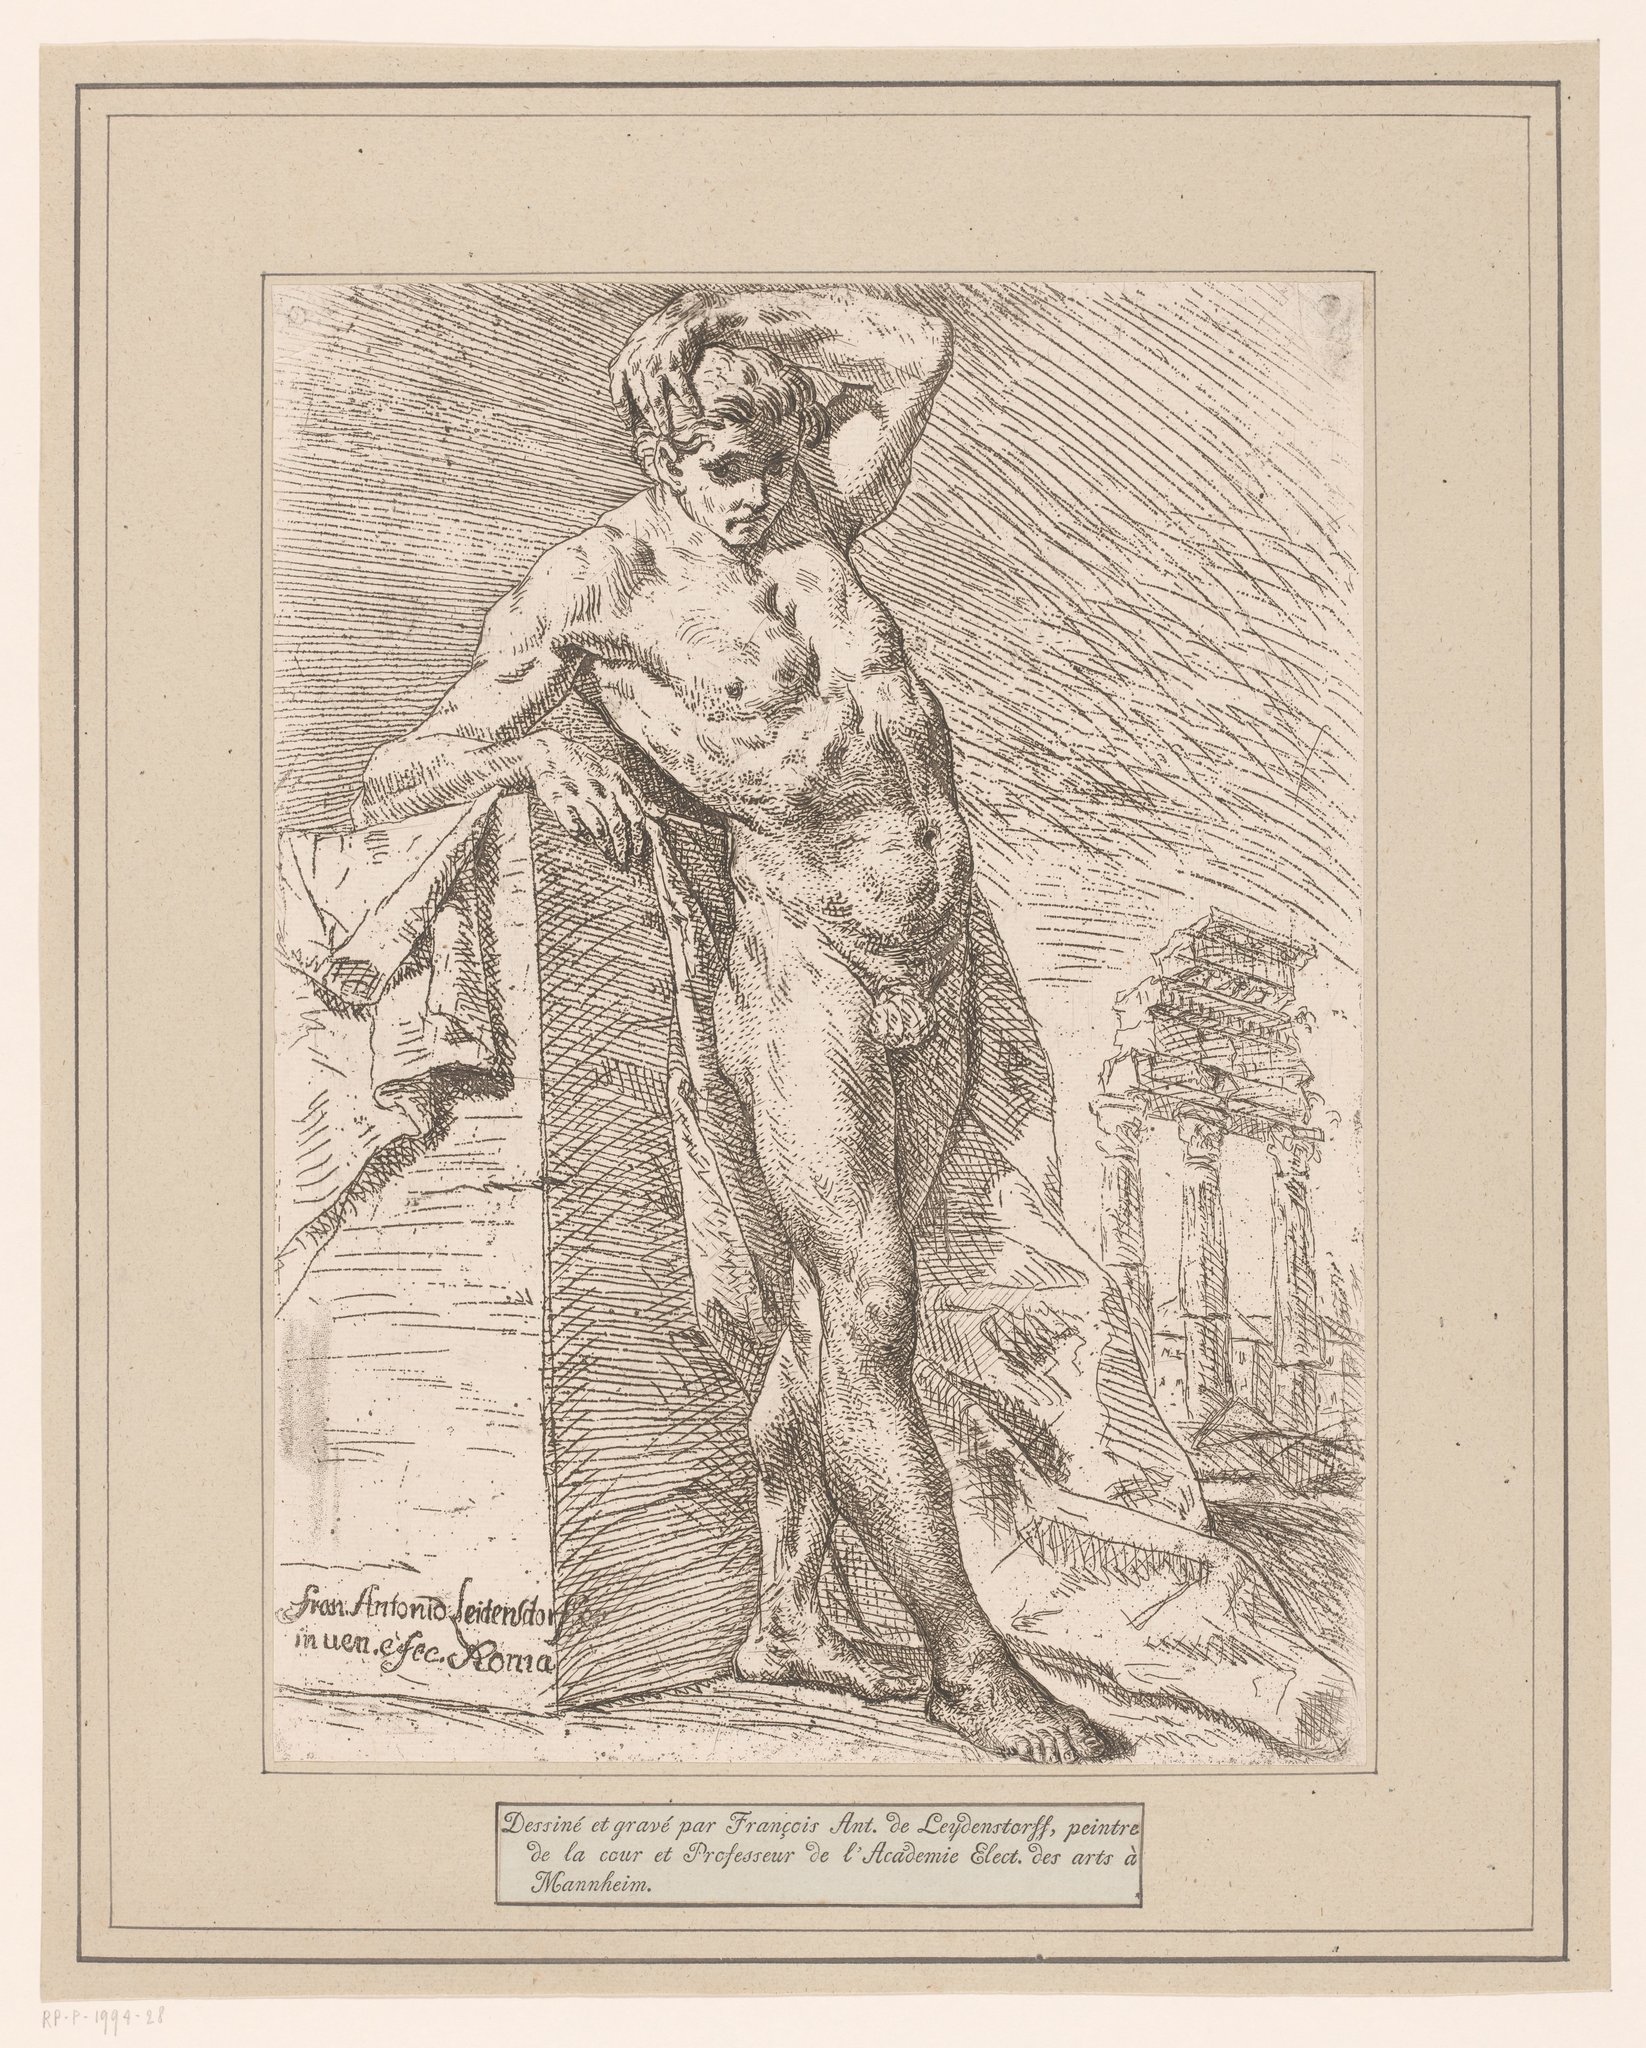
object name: print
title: Staand mannelijk naakt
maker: franz anton von leitenstorffer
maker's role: print maker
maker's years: 1721-1795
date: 1742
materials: paper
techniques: engraving, etching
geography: rome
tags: artist (in general) working from nude model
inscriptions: collector's mark: Lugt 2228